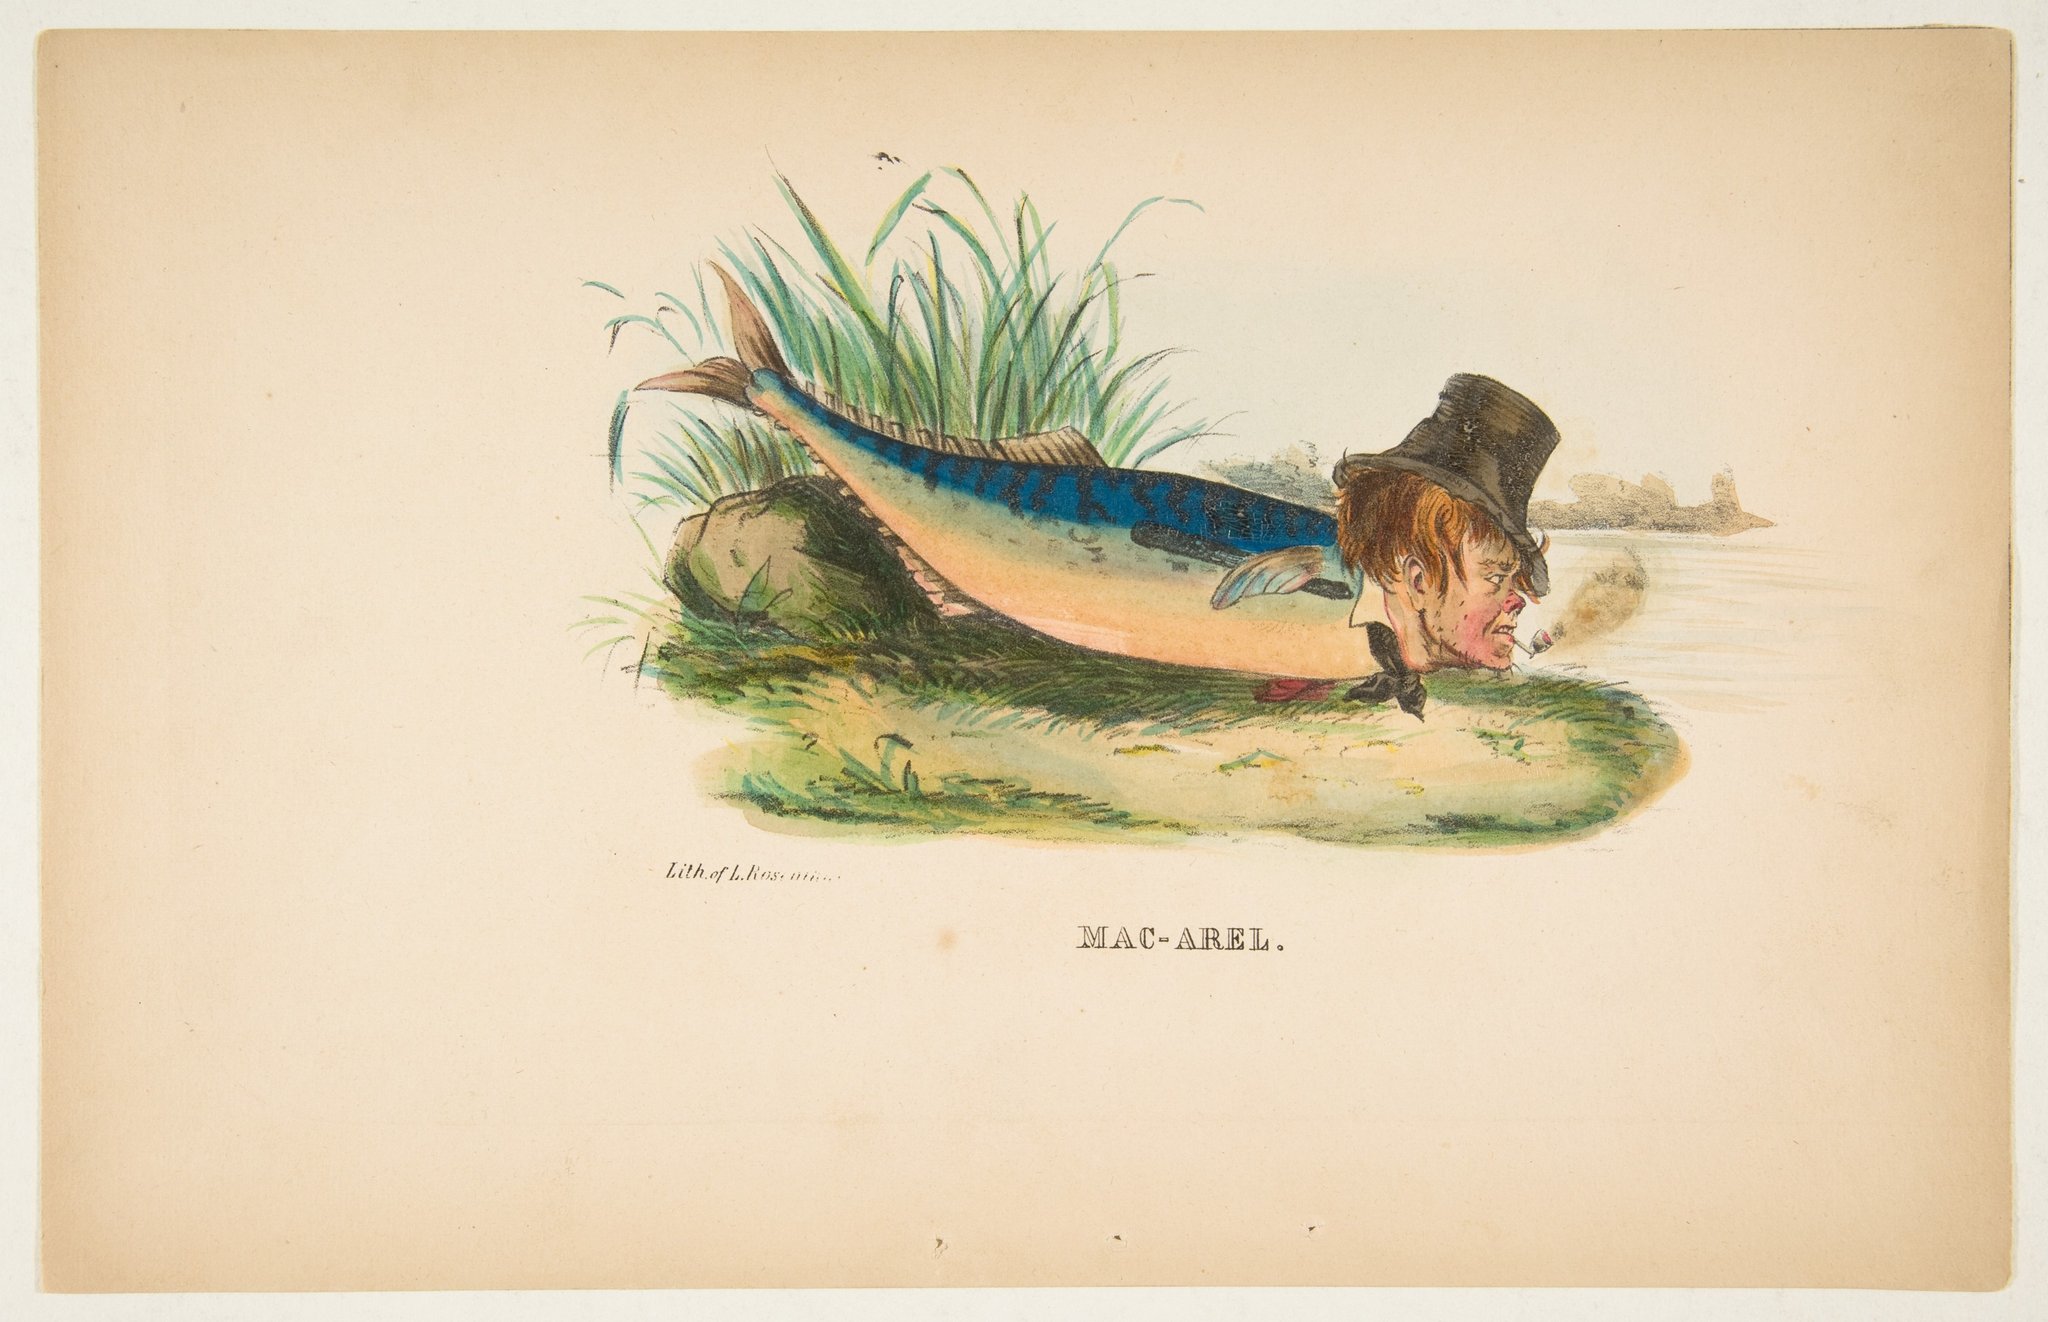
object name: print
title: Mac-Arel, from "The Comic Natural History of the Human Race"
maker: henry louis stephens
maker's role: artist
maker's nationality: american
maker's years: 1824-1882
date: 1851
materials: watercolor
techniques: lithograph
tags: satire,smoking